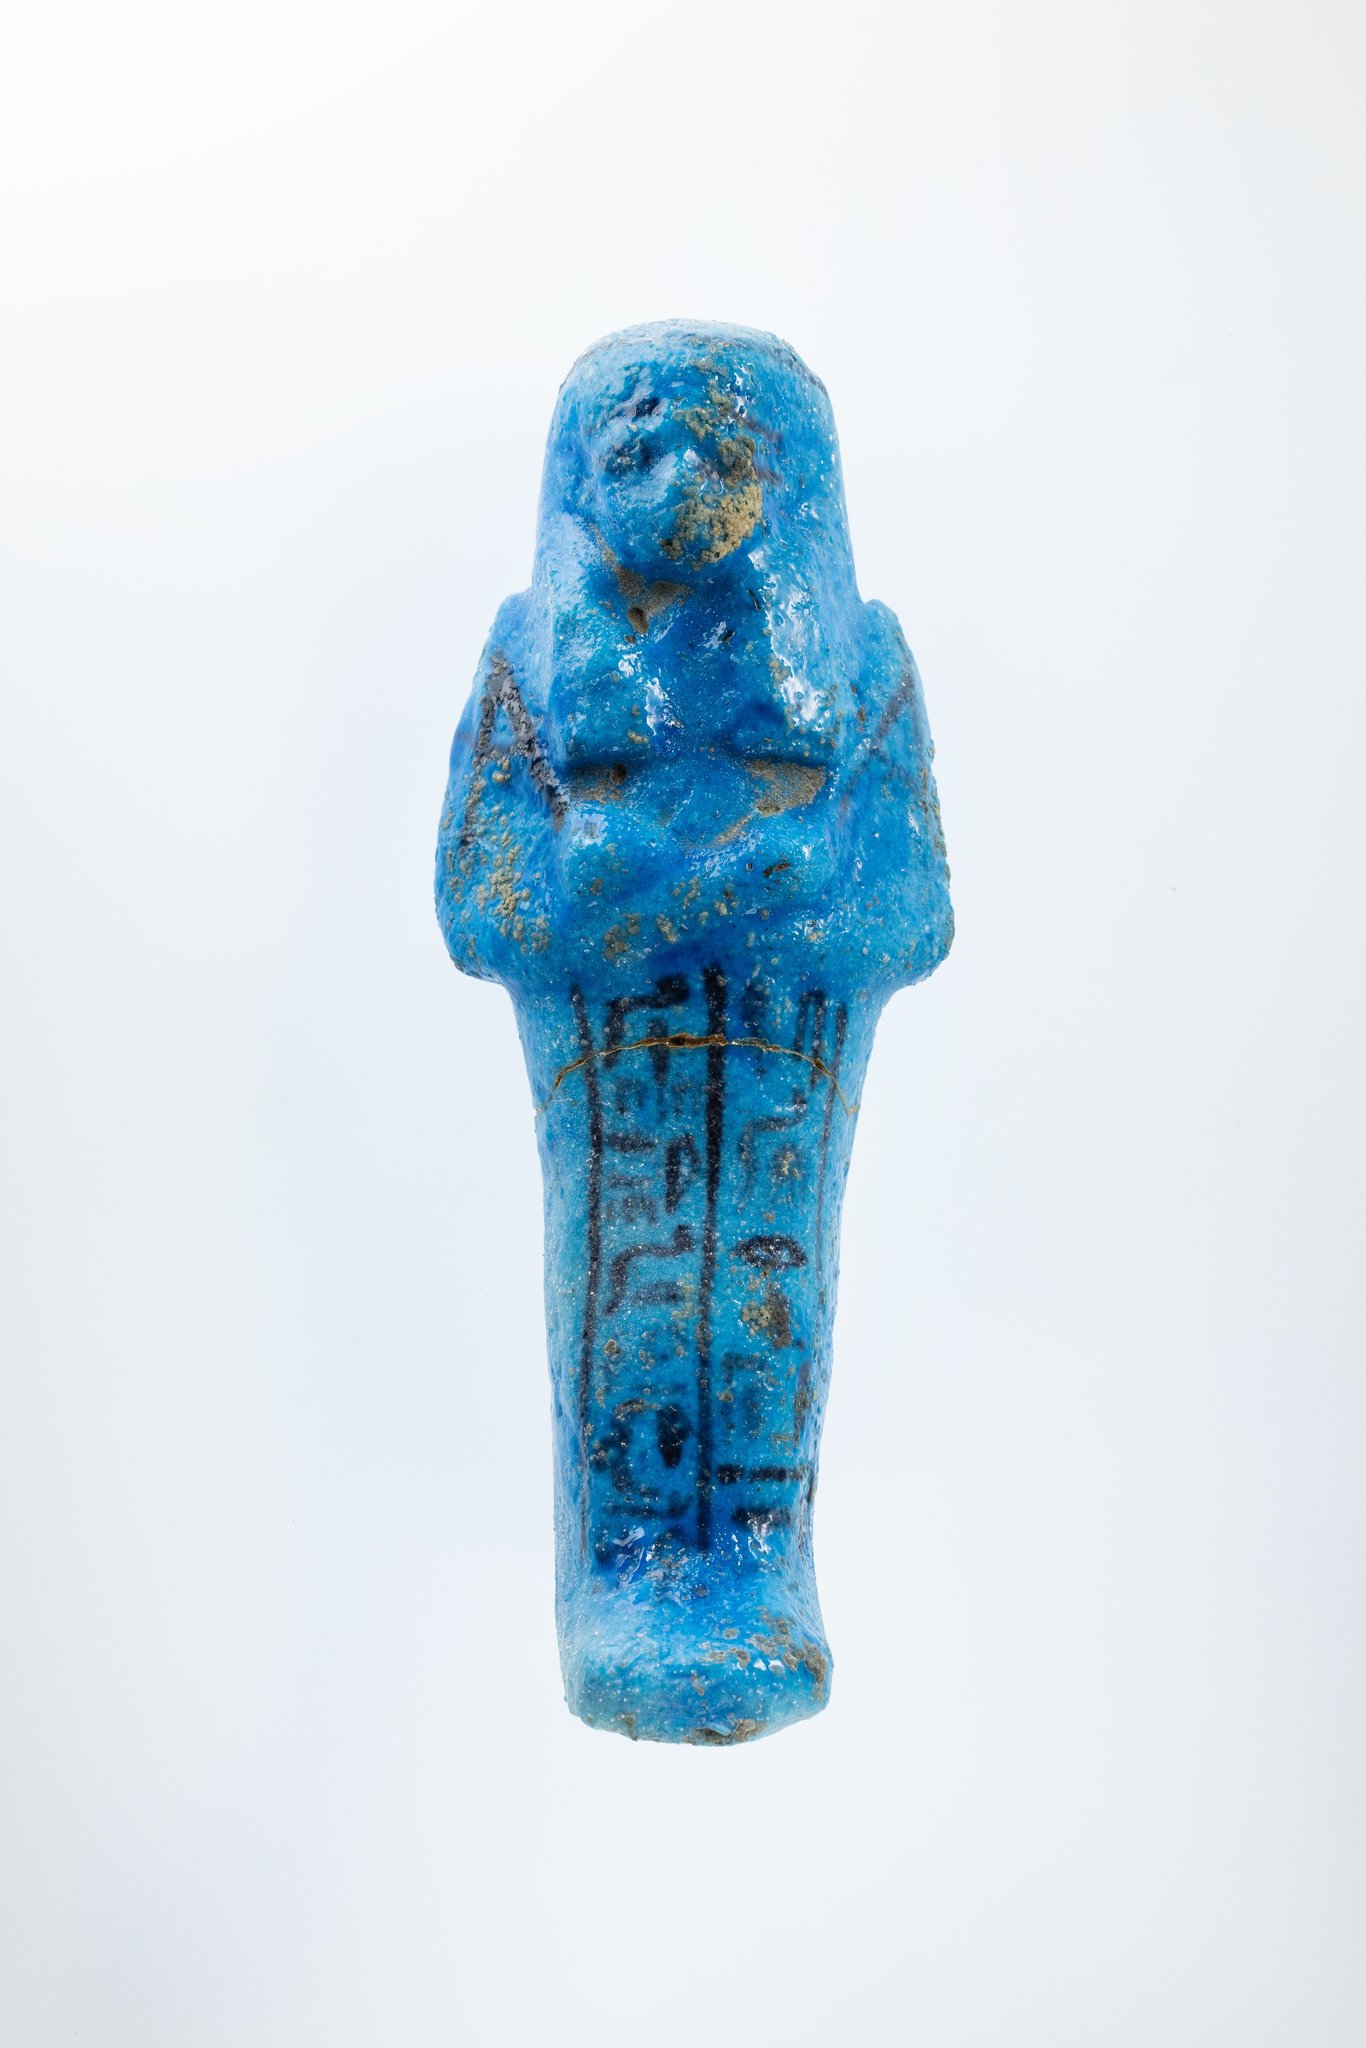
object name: shabti, djedkhonsuefankh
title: Shabti of Djedkhonsuefankh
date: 1070-945 BCE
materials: faience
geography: egypt